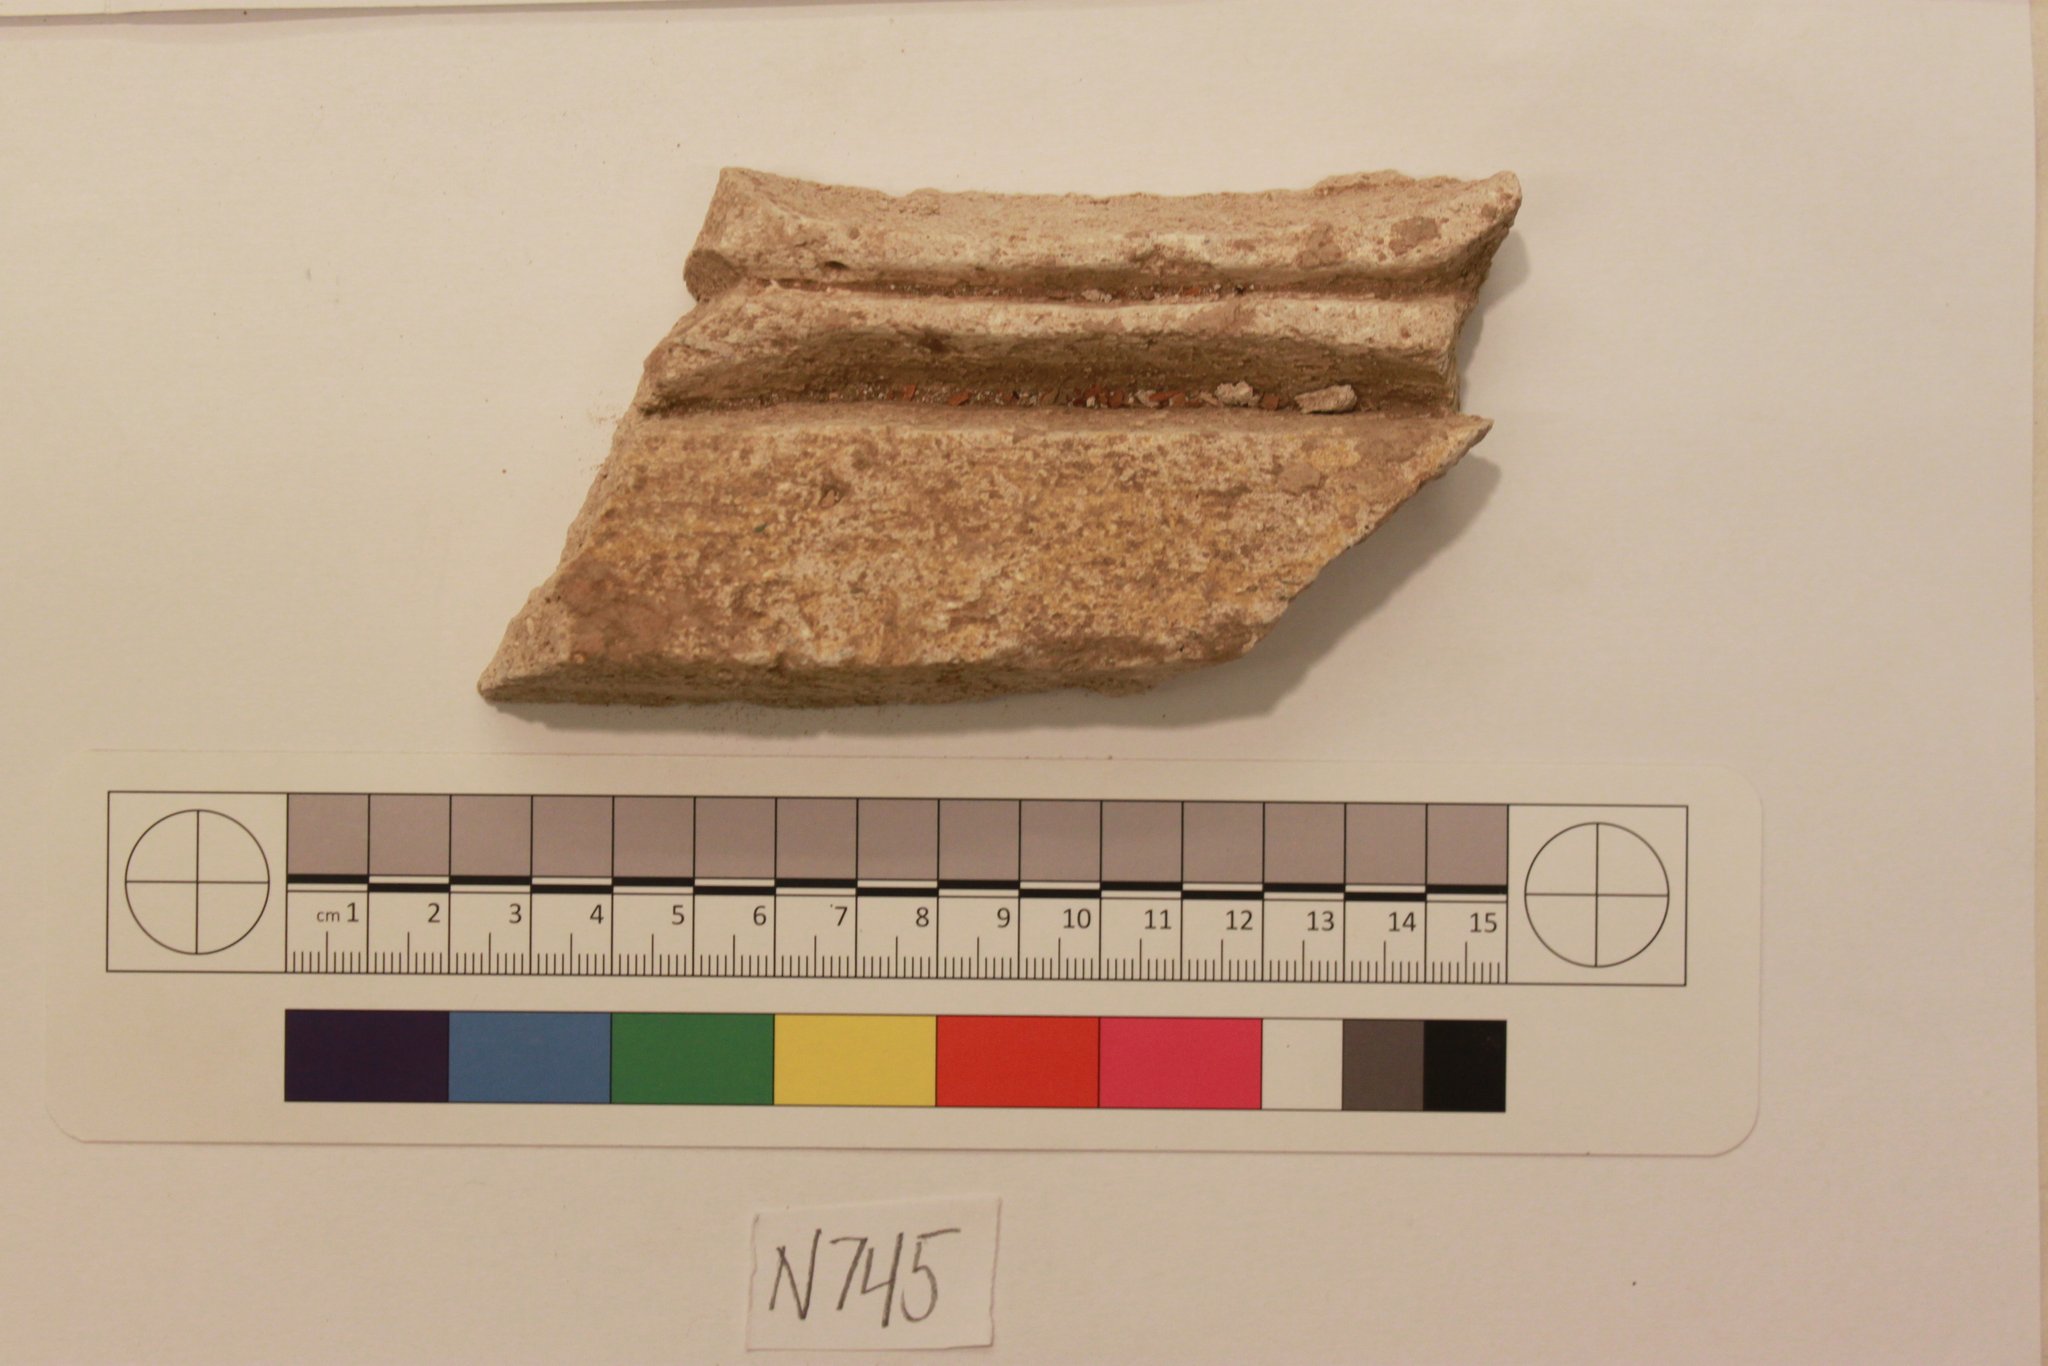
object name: fragment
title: Stucco Fragment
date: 701-1200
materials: plaster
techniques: carving, painting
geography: iran